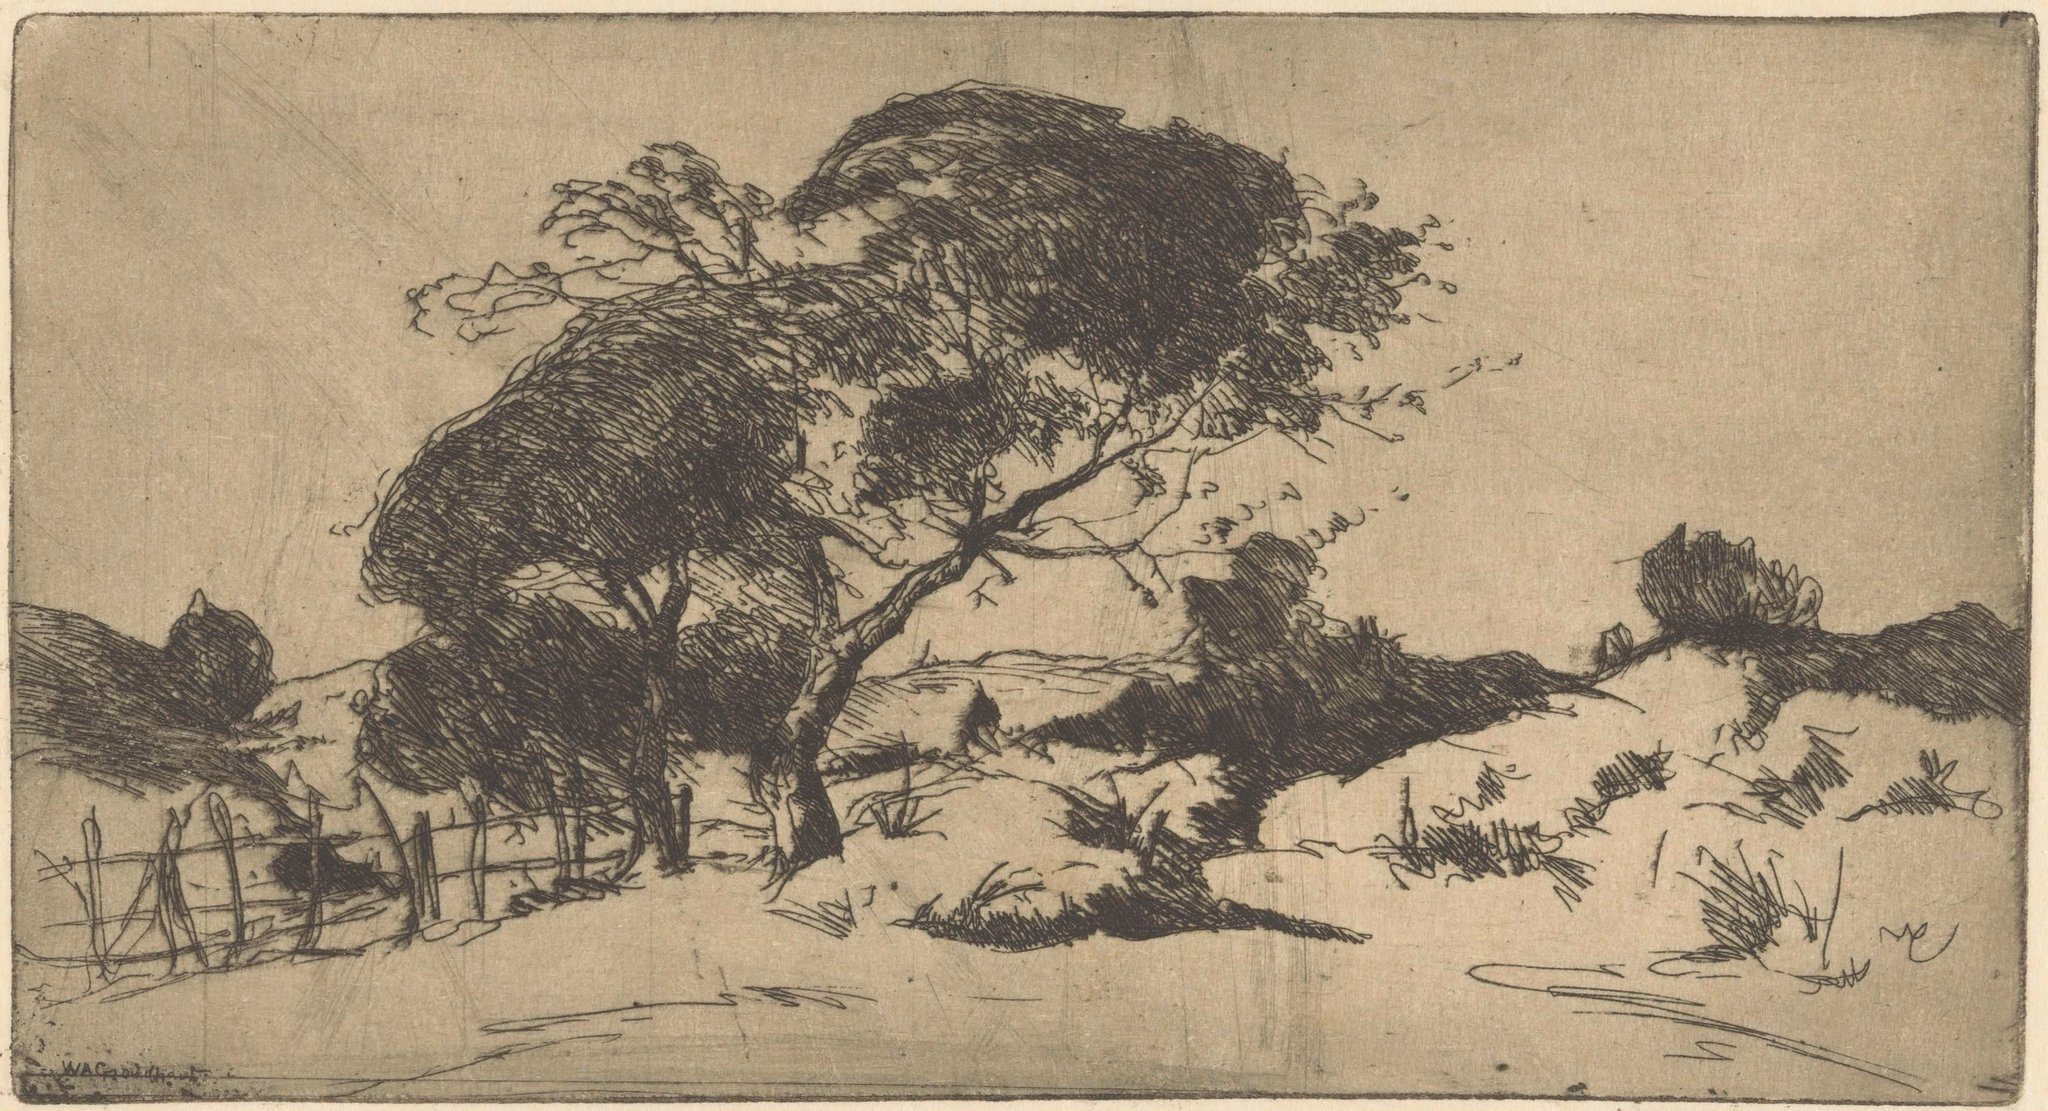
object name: print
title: Duinlandschap bij Den Haag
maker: willem adrianus grondhout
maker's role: draughtsman, painter, print maker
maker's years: 1878-1934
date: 1915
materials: paper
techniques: etching, intaglio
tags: dunes (sea not visible); in the dunes, the hague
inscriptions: collector's mark: Lugt 2228